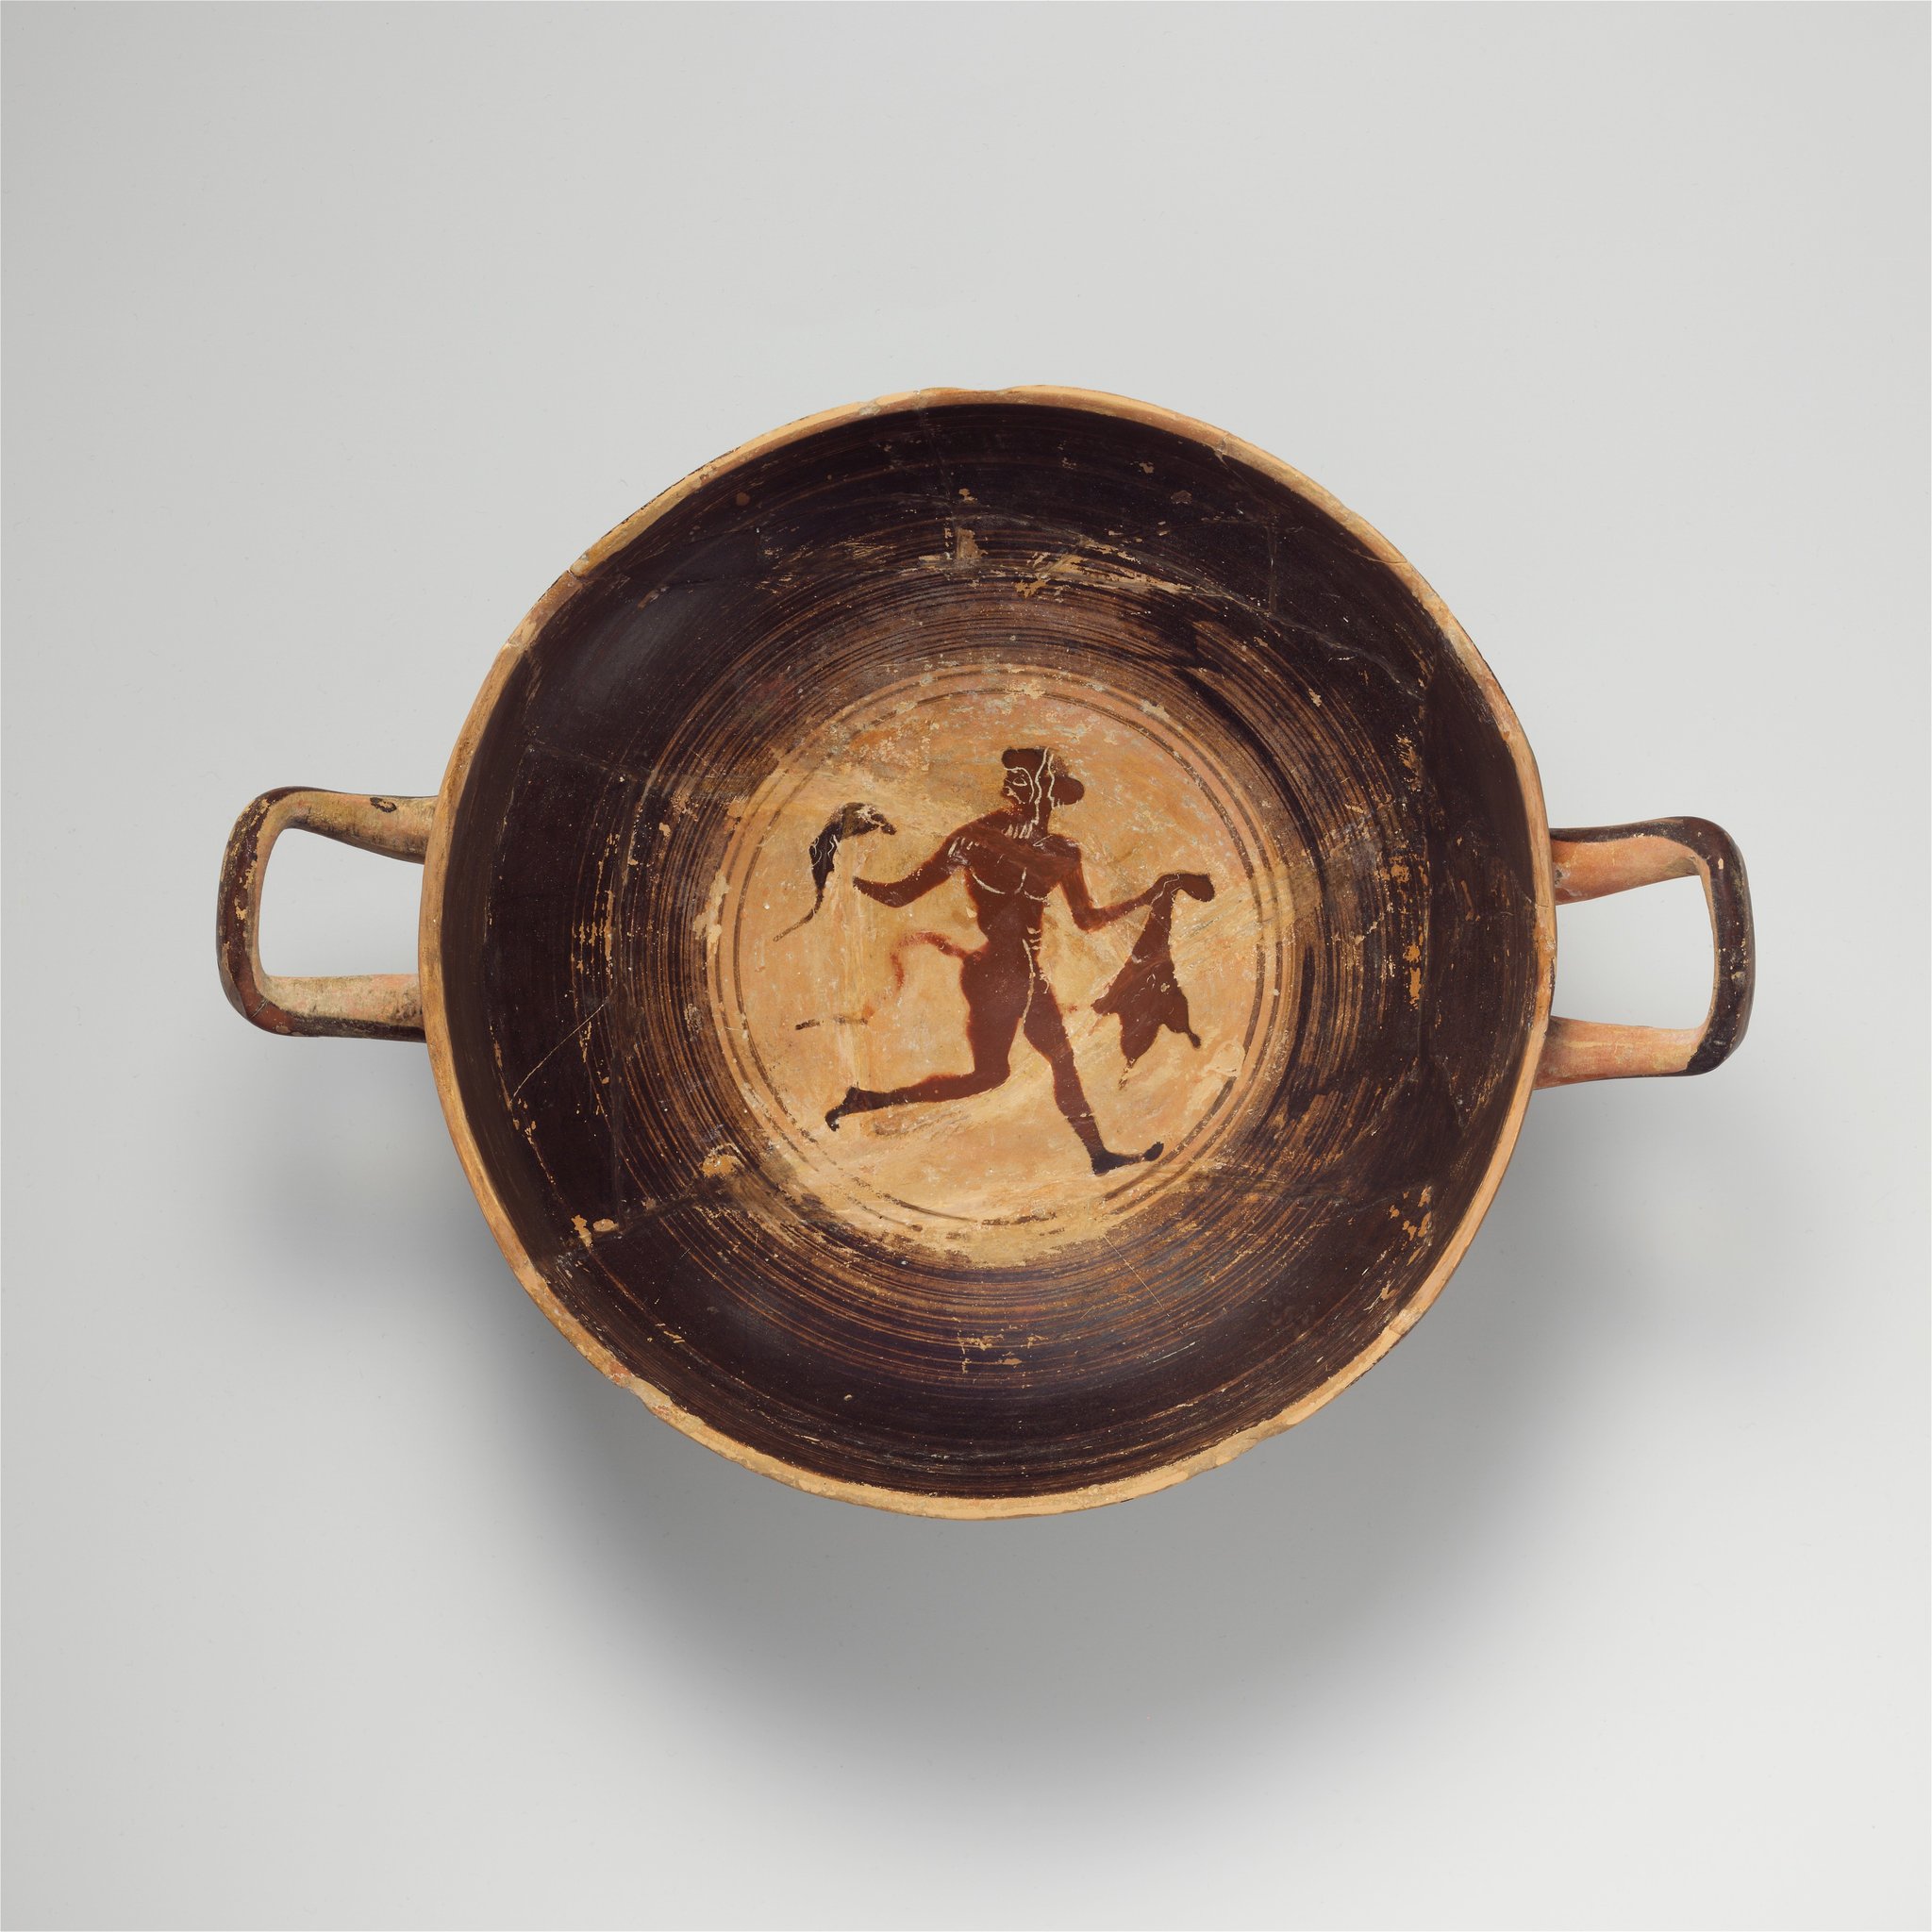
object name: kylix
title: Terracotta kylix (drinking cup)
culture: greek, attic or boeotian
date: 480-470 BCE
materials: terracotta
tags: satyrs